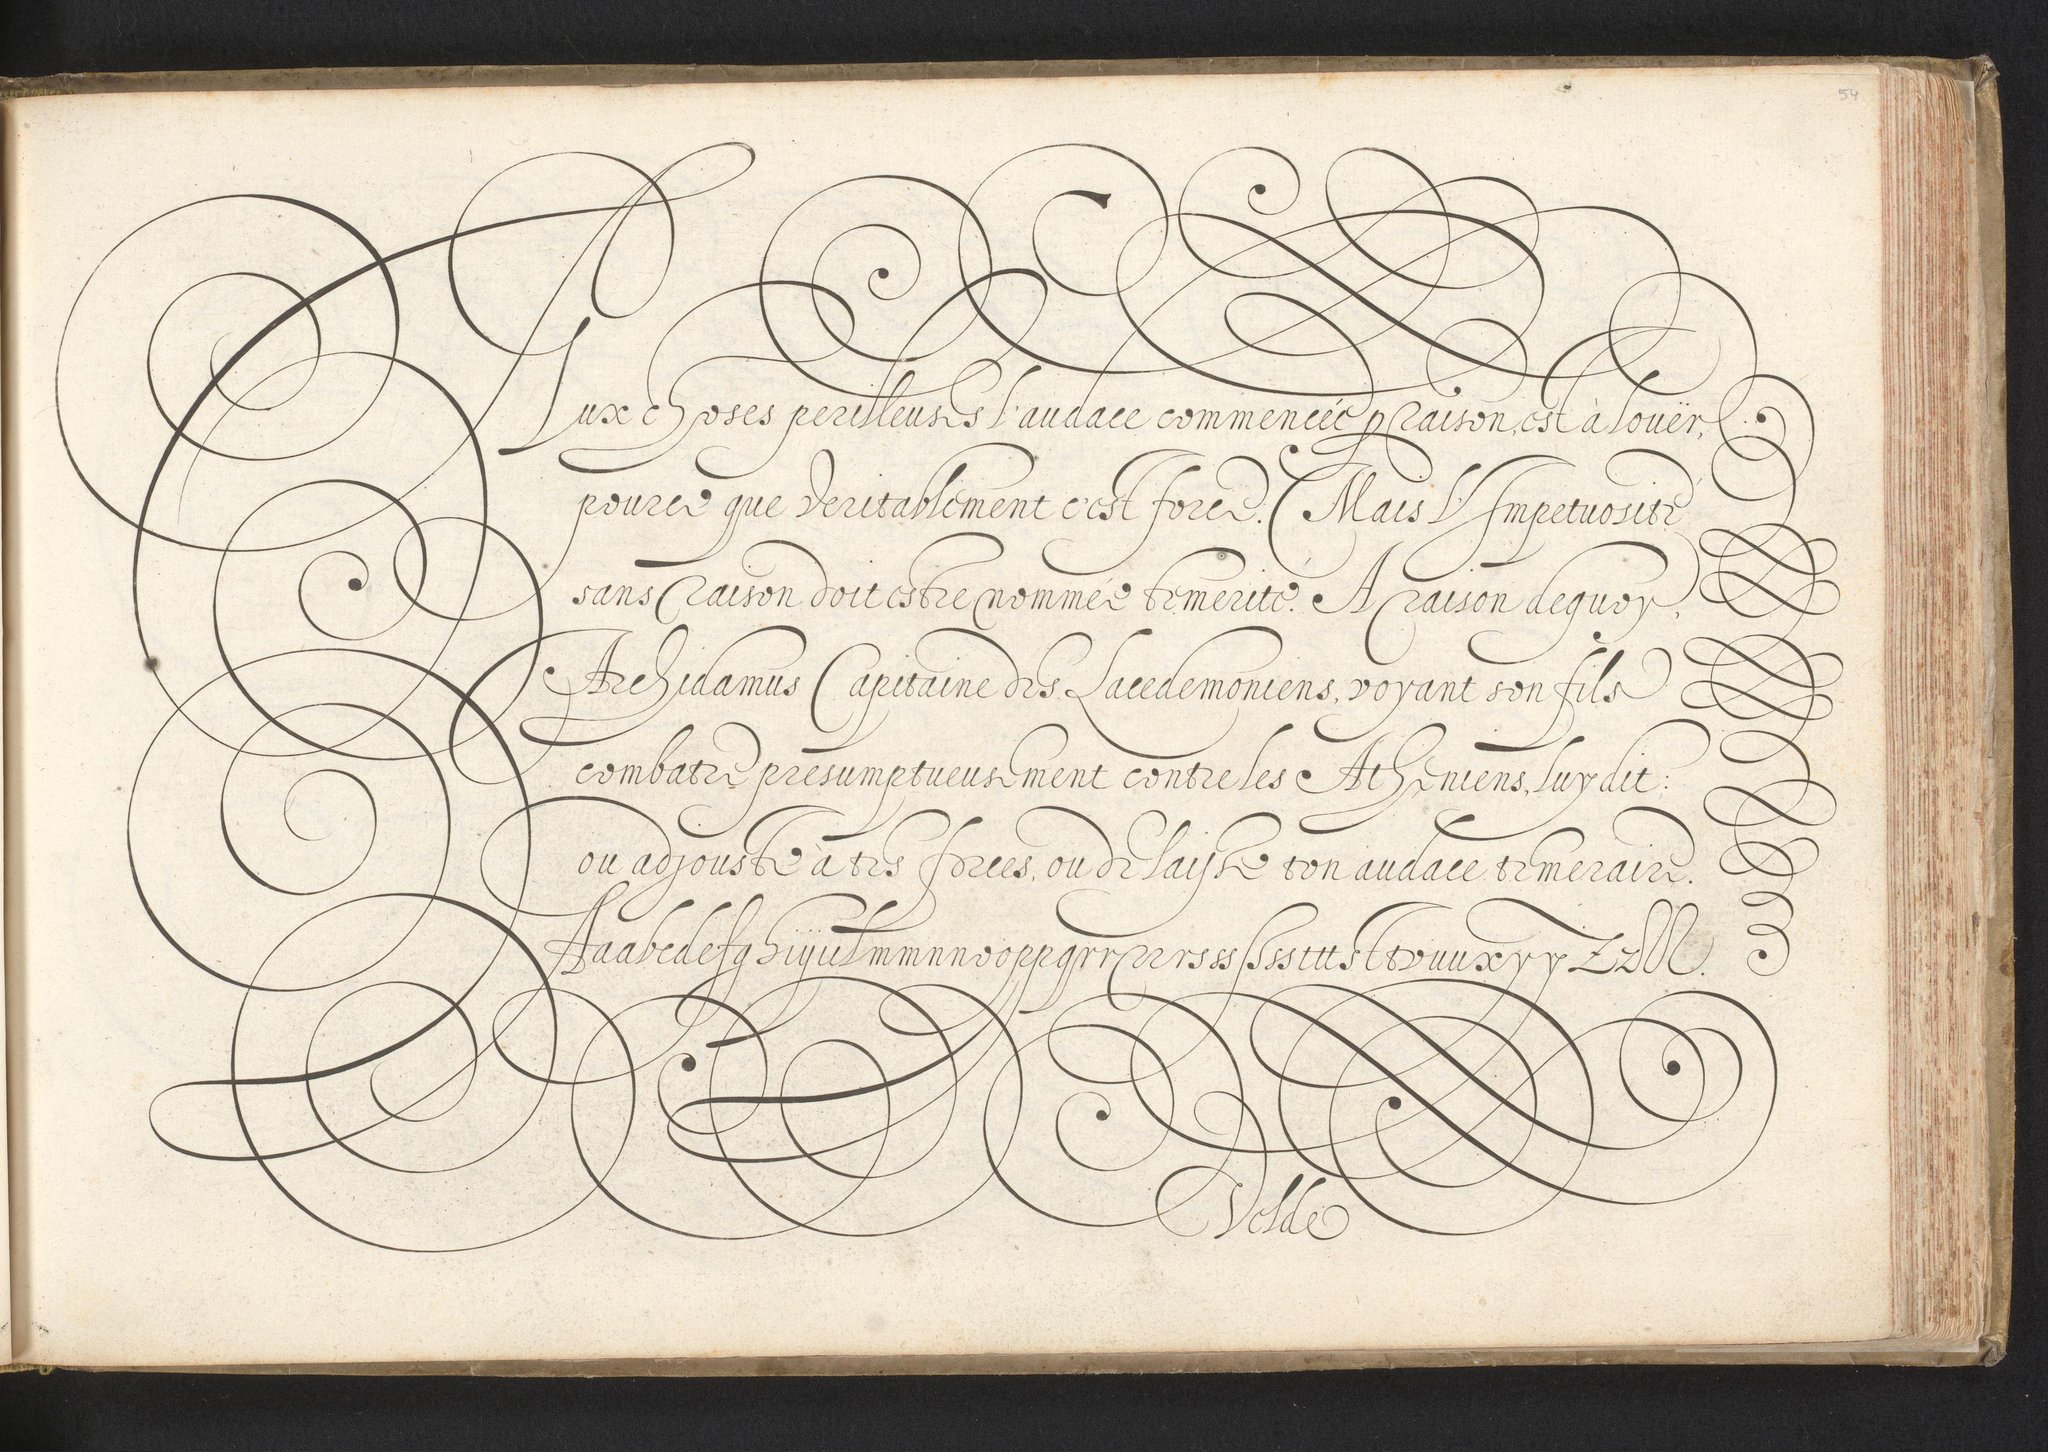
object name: print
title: Thrésor litéraire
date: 1605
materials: paper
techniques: engraving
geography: rotterdam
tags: calligraphy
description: Schrijfvoorbeeld met zeven regels tekst in het Frans: Lux choses perilleuses ... De tekst is omlijst met krulwerk. De prent maakt deel uit van een album.